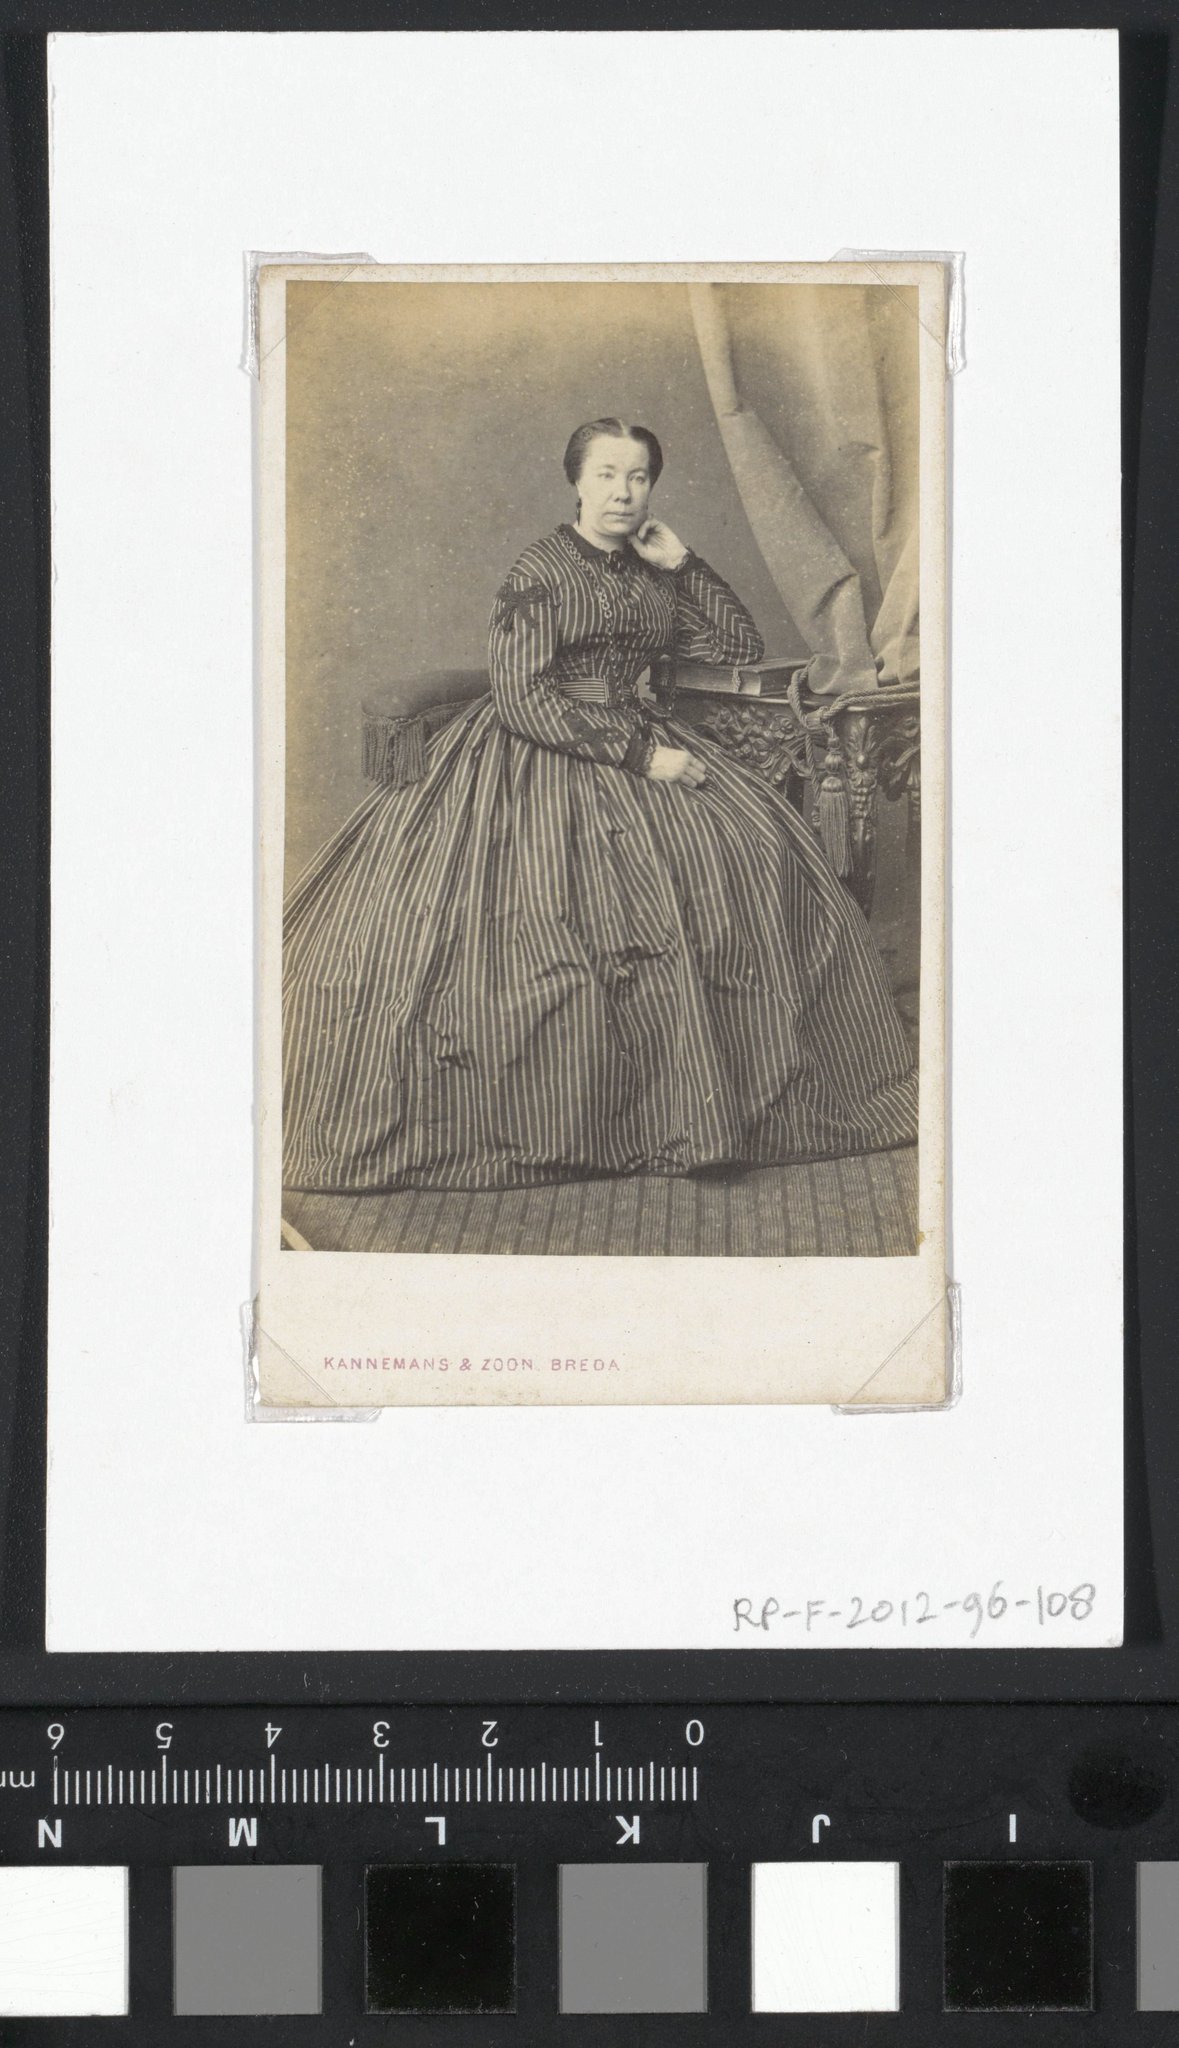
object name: photograph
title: Portret van een vrouw in een gestreepte lange jurk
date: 1860-1884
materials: cardboard, paper, photographic support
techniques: albumen print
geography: breda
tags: studio requisites ~ photographer, historical persons not known by name - bb - woman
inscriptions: address: ‘Breda Groote Markt D.15 tegen over het stadhuis’